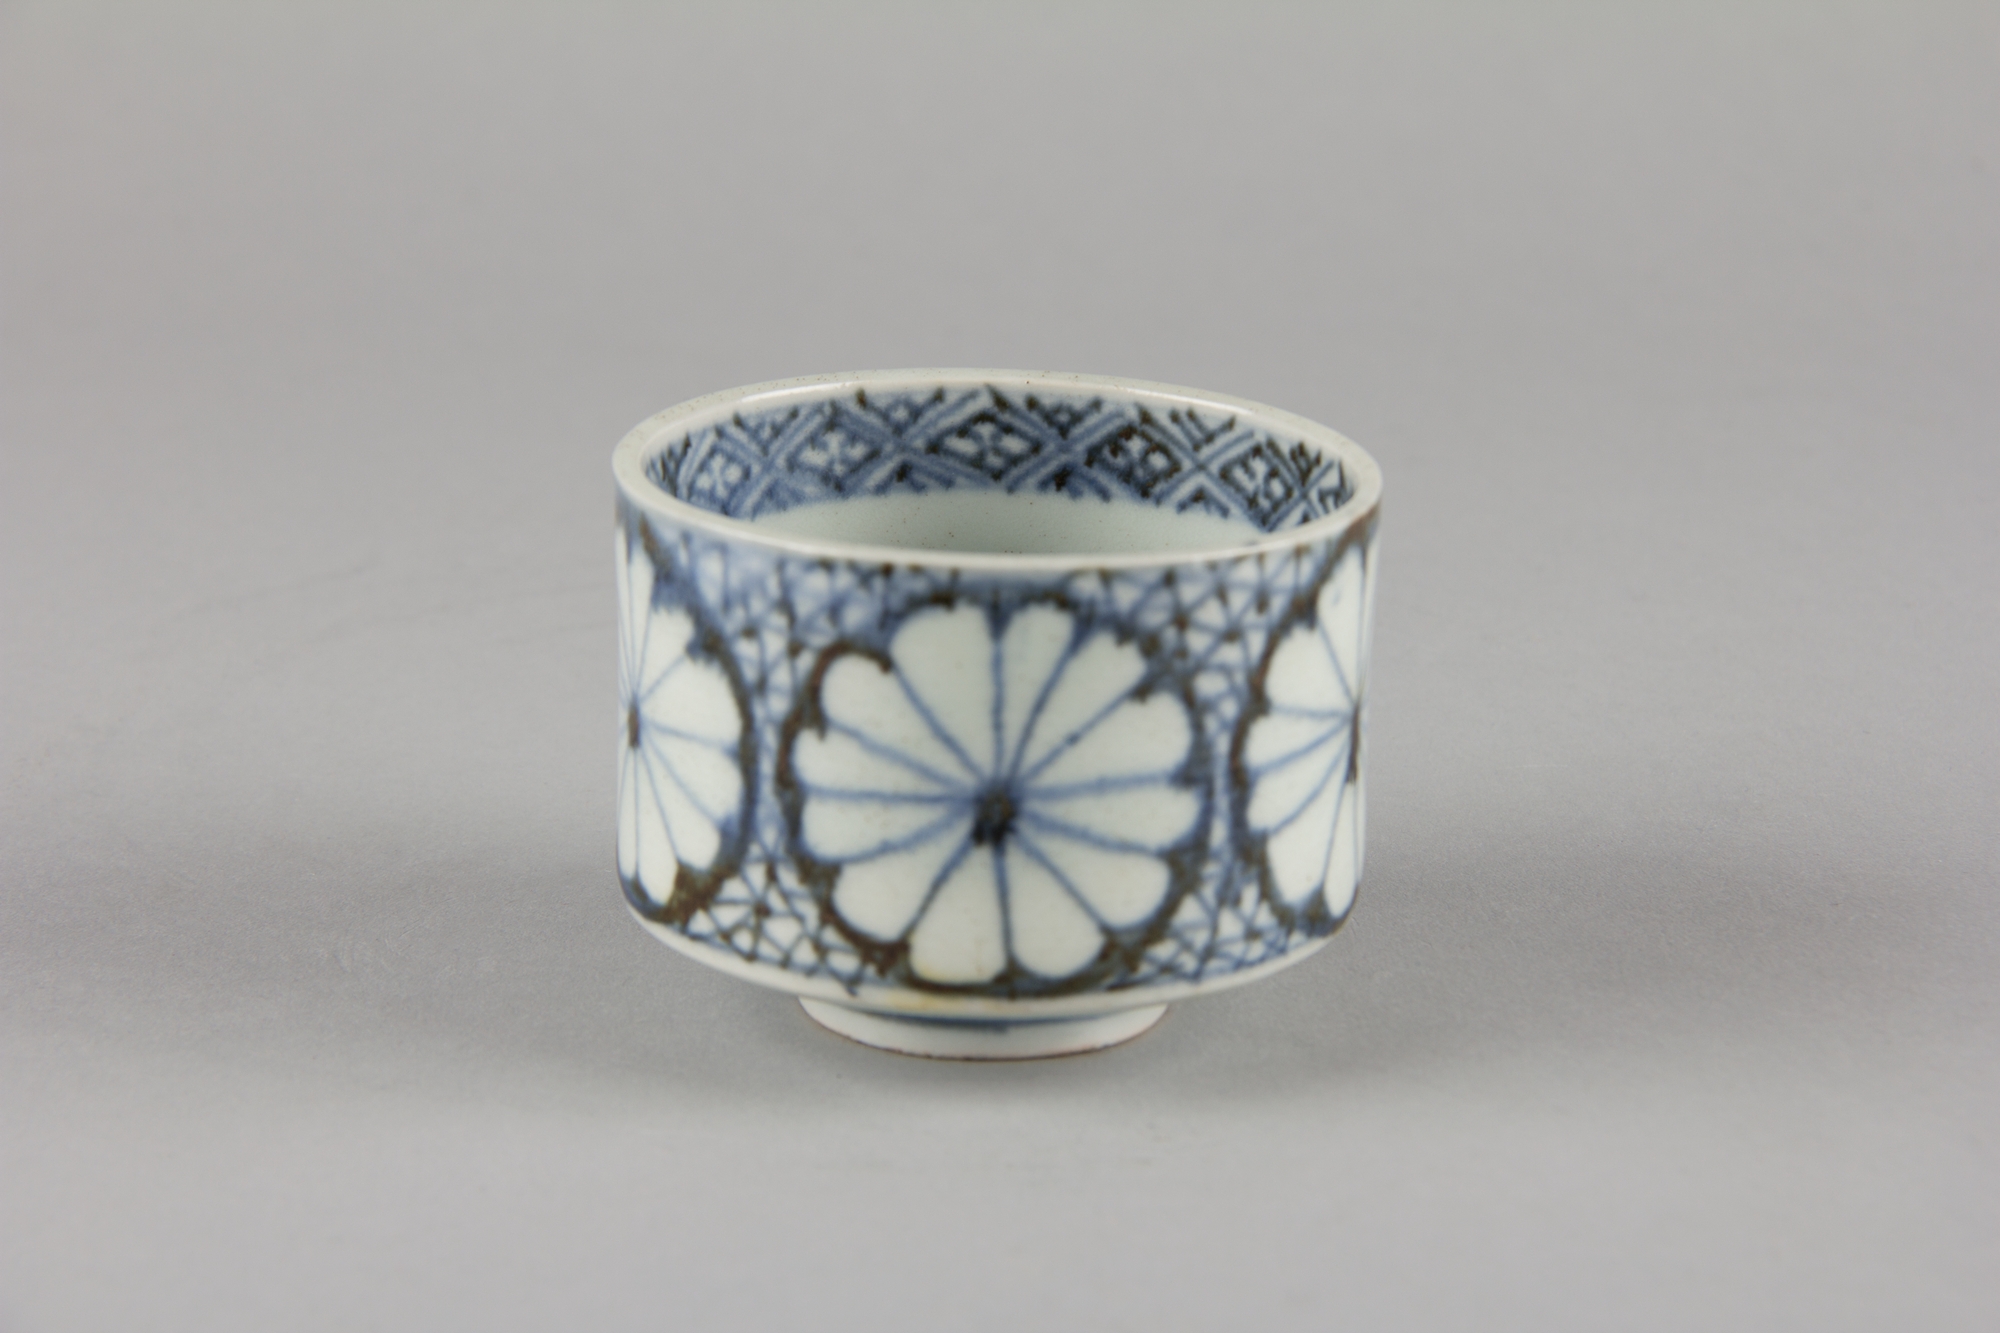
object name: soba cup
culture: japanese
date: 1801-1900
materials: cobalt, porcelain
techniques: painting, underglaze